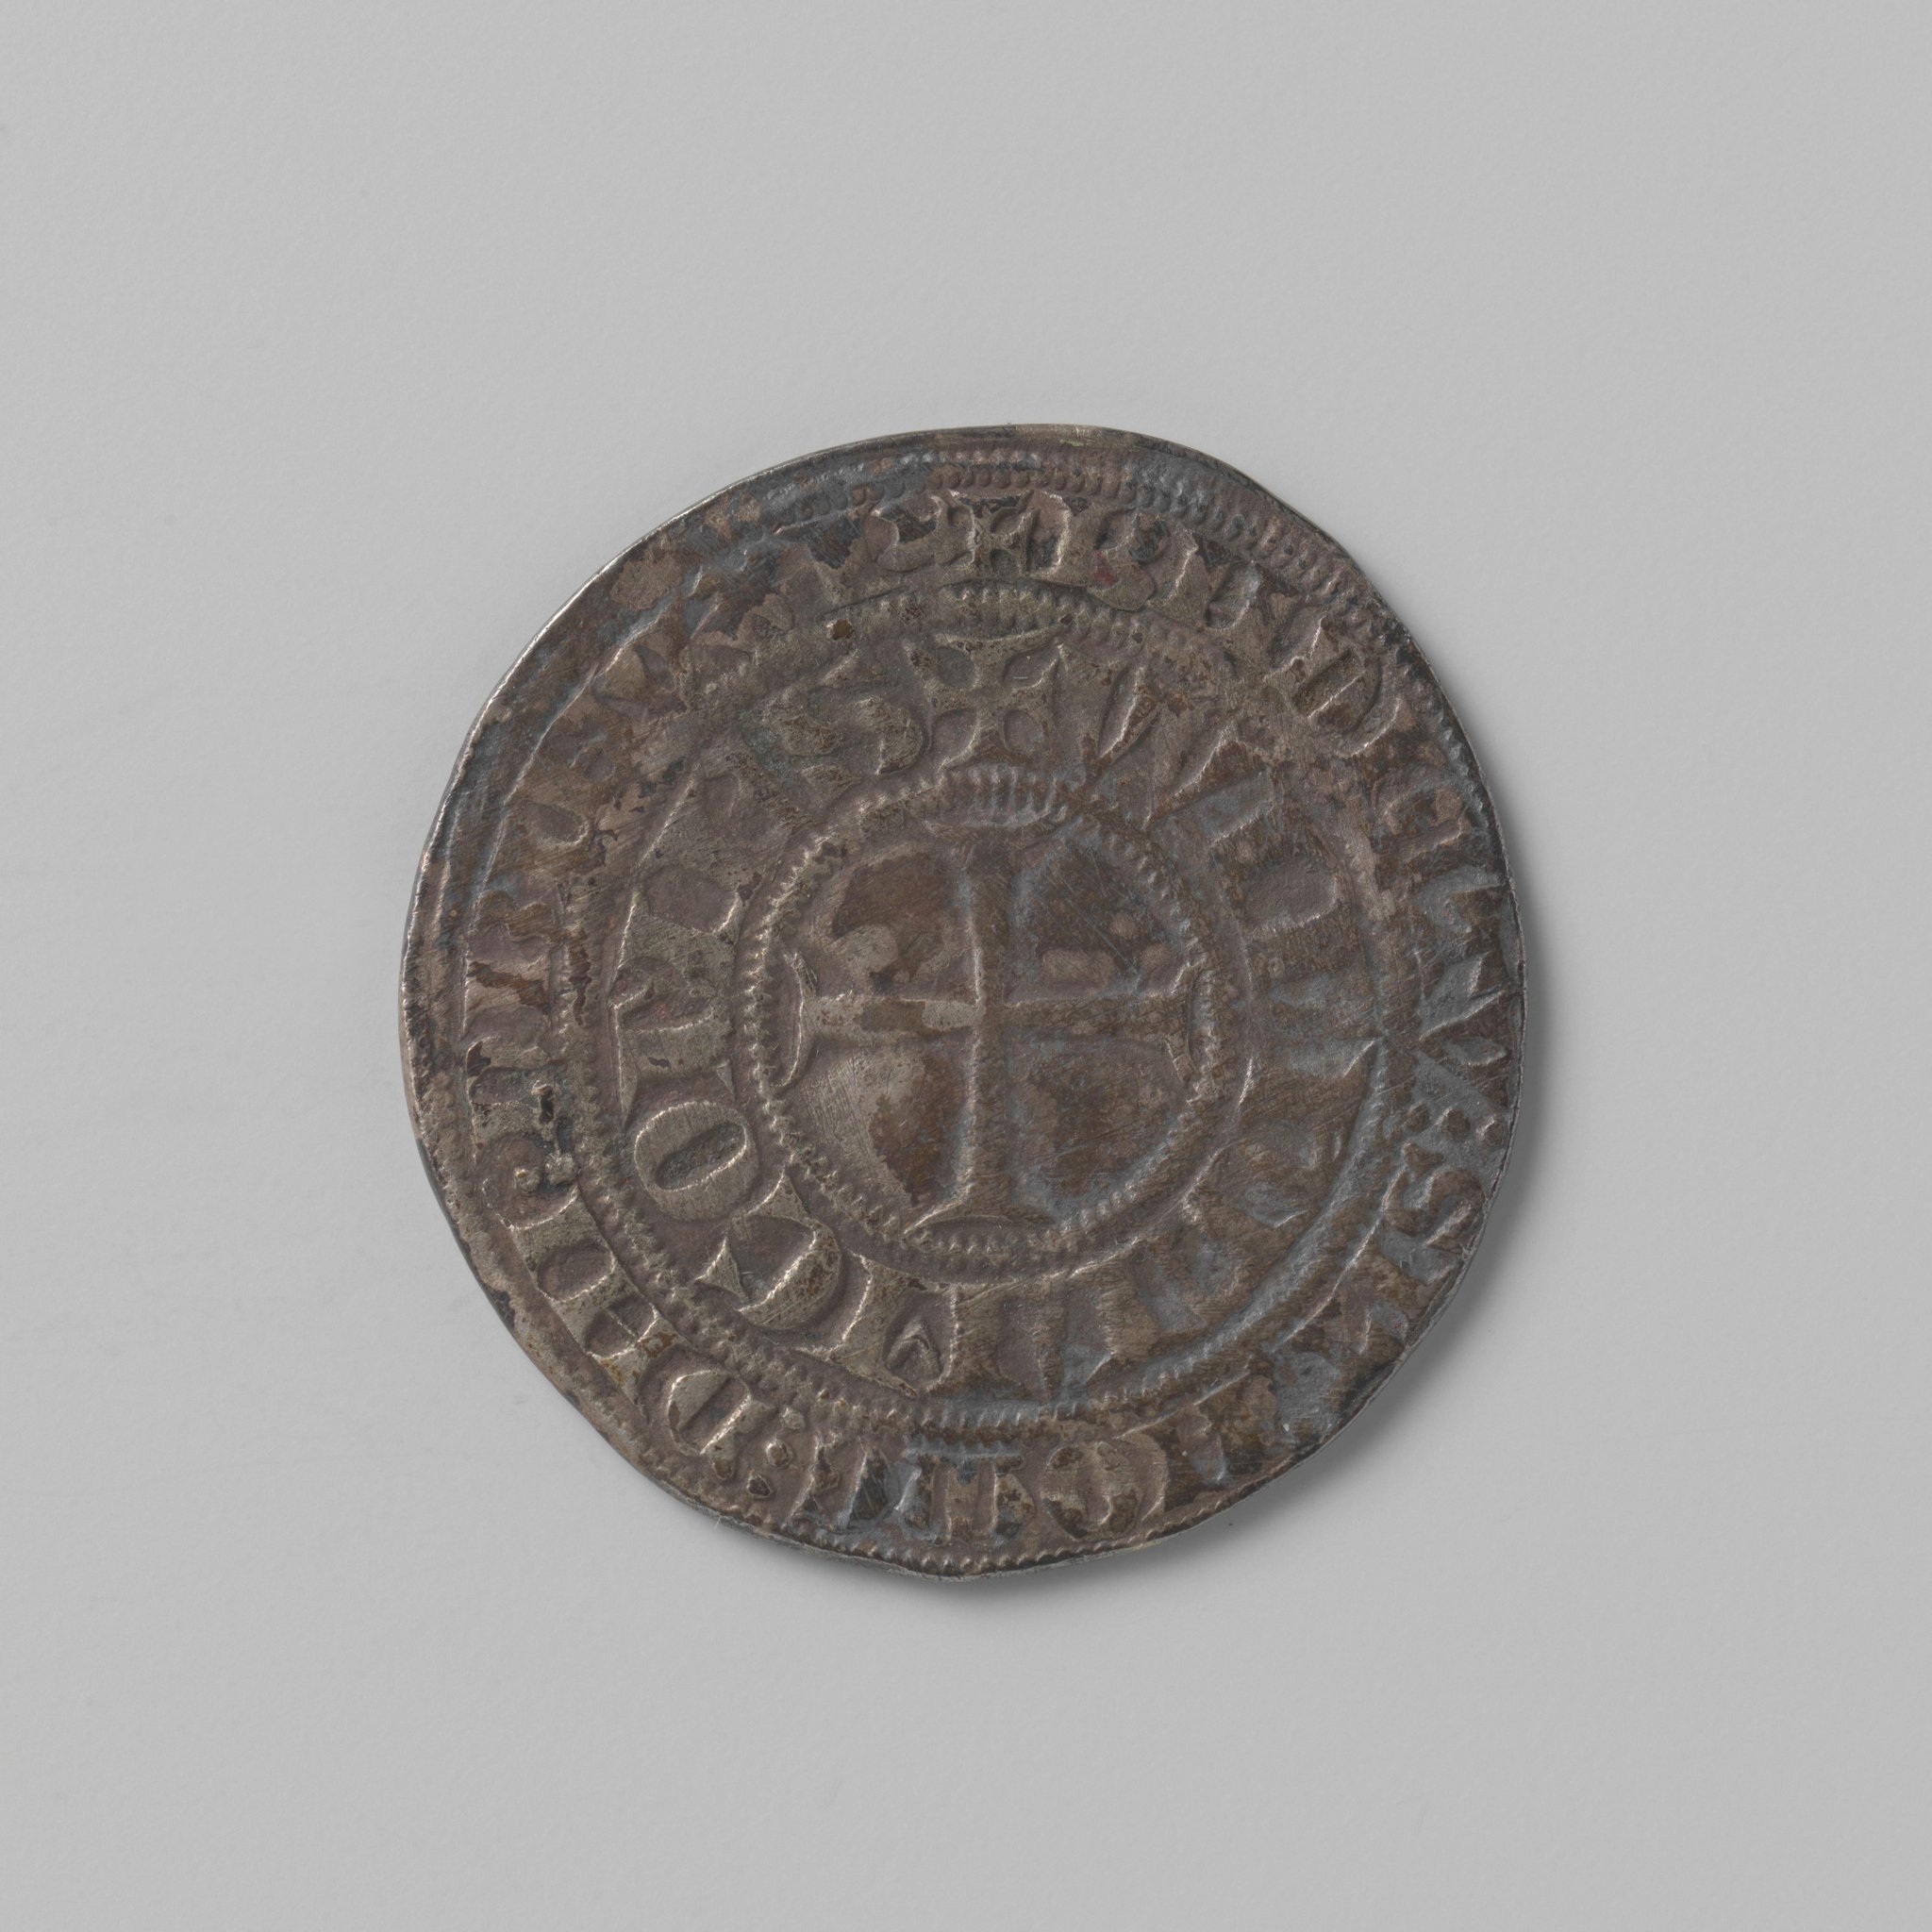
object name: coin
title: Gulik-Berg, Willem II, tourse groot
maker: willem iv (graaf van holland)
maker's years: 1307-1345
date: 1337-1345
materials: silver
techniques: striking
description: Zilveren munt. Voorzijde: kasteel met omschrift binnen rand van twaalf schildjes. Keerzijde: kort gevoet kruis binnen dubbel omschrift.